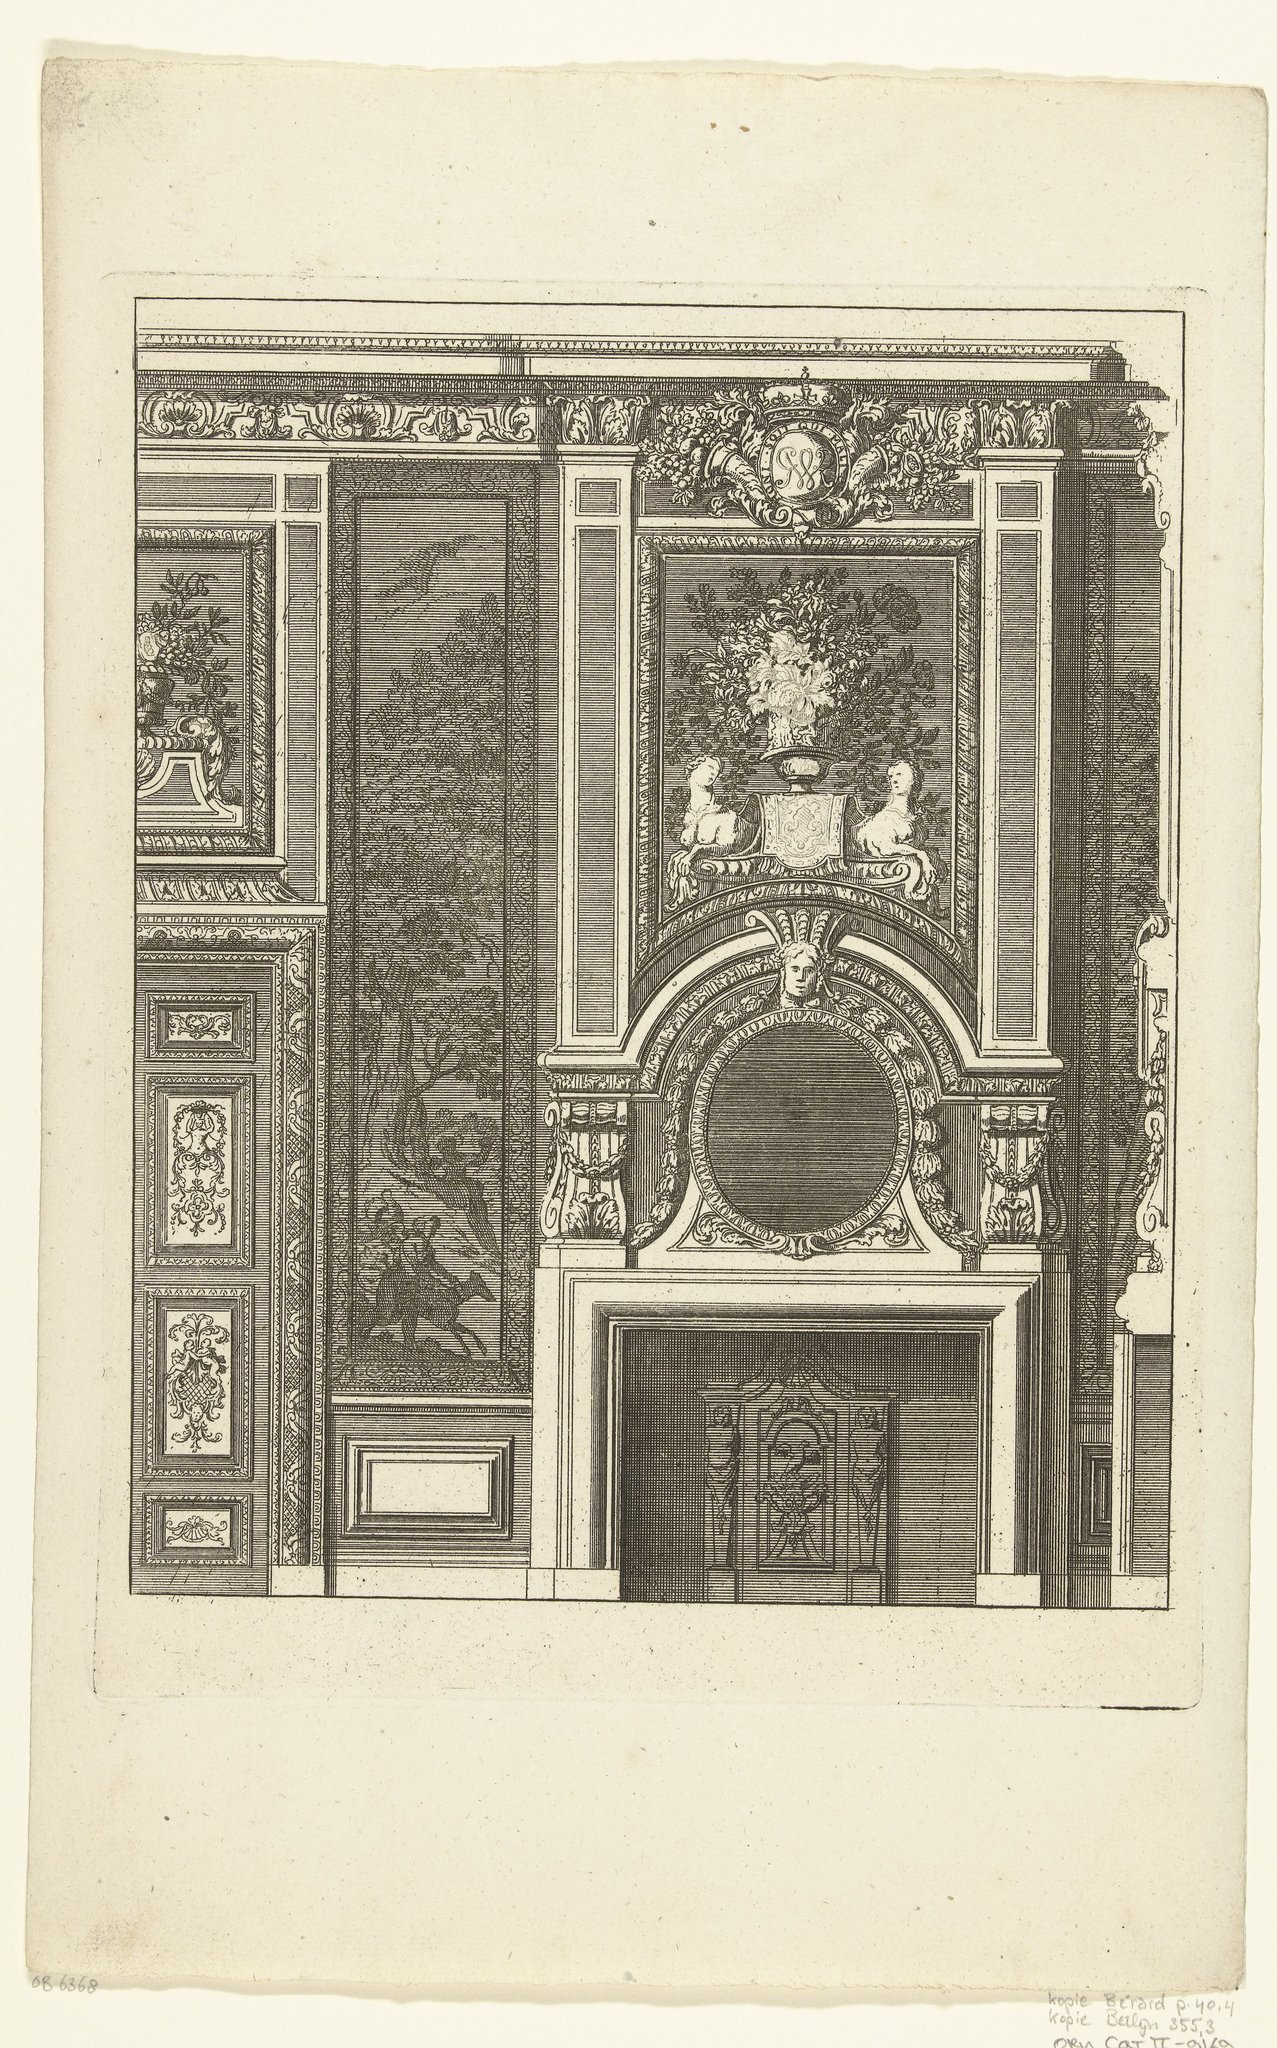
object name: print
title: Schouw voor een wand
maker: Anonymous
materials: paper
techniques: etching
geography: netherlands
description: Links is een halve deur zichtbaar met een bovendeurspaneel. Tussen de schoorsteenboezem en de gebogen kroonlijst hangt een spiegel, daarboven staat een vaas met bloemen. Helemaal bovenaan is het bekroonde monogram WR (William Rex) zichtbaar. Kopie naar prent uit de serie Nouvelles Cheminée faittes en plusieur en droits de la Hollande et autres Prouinces.